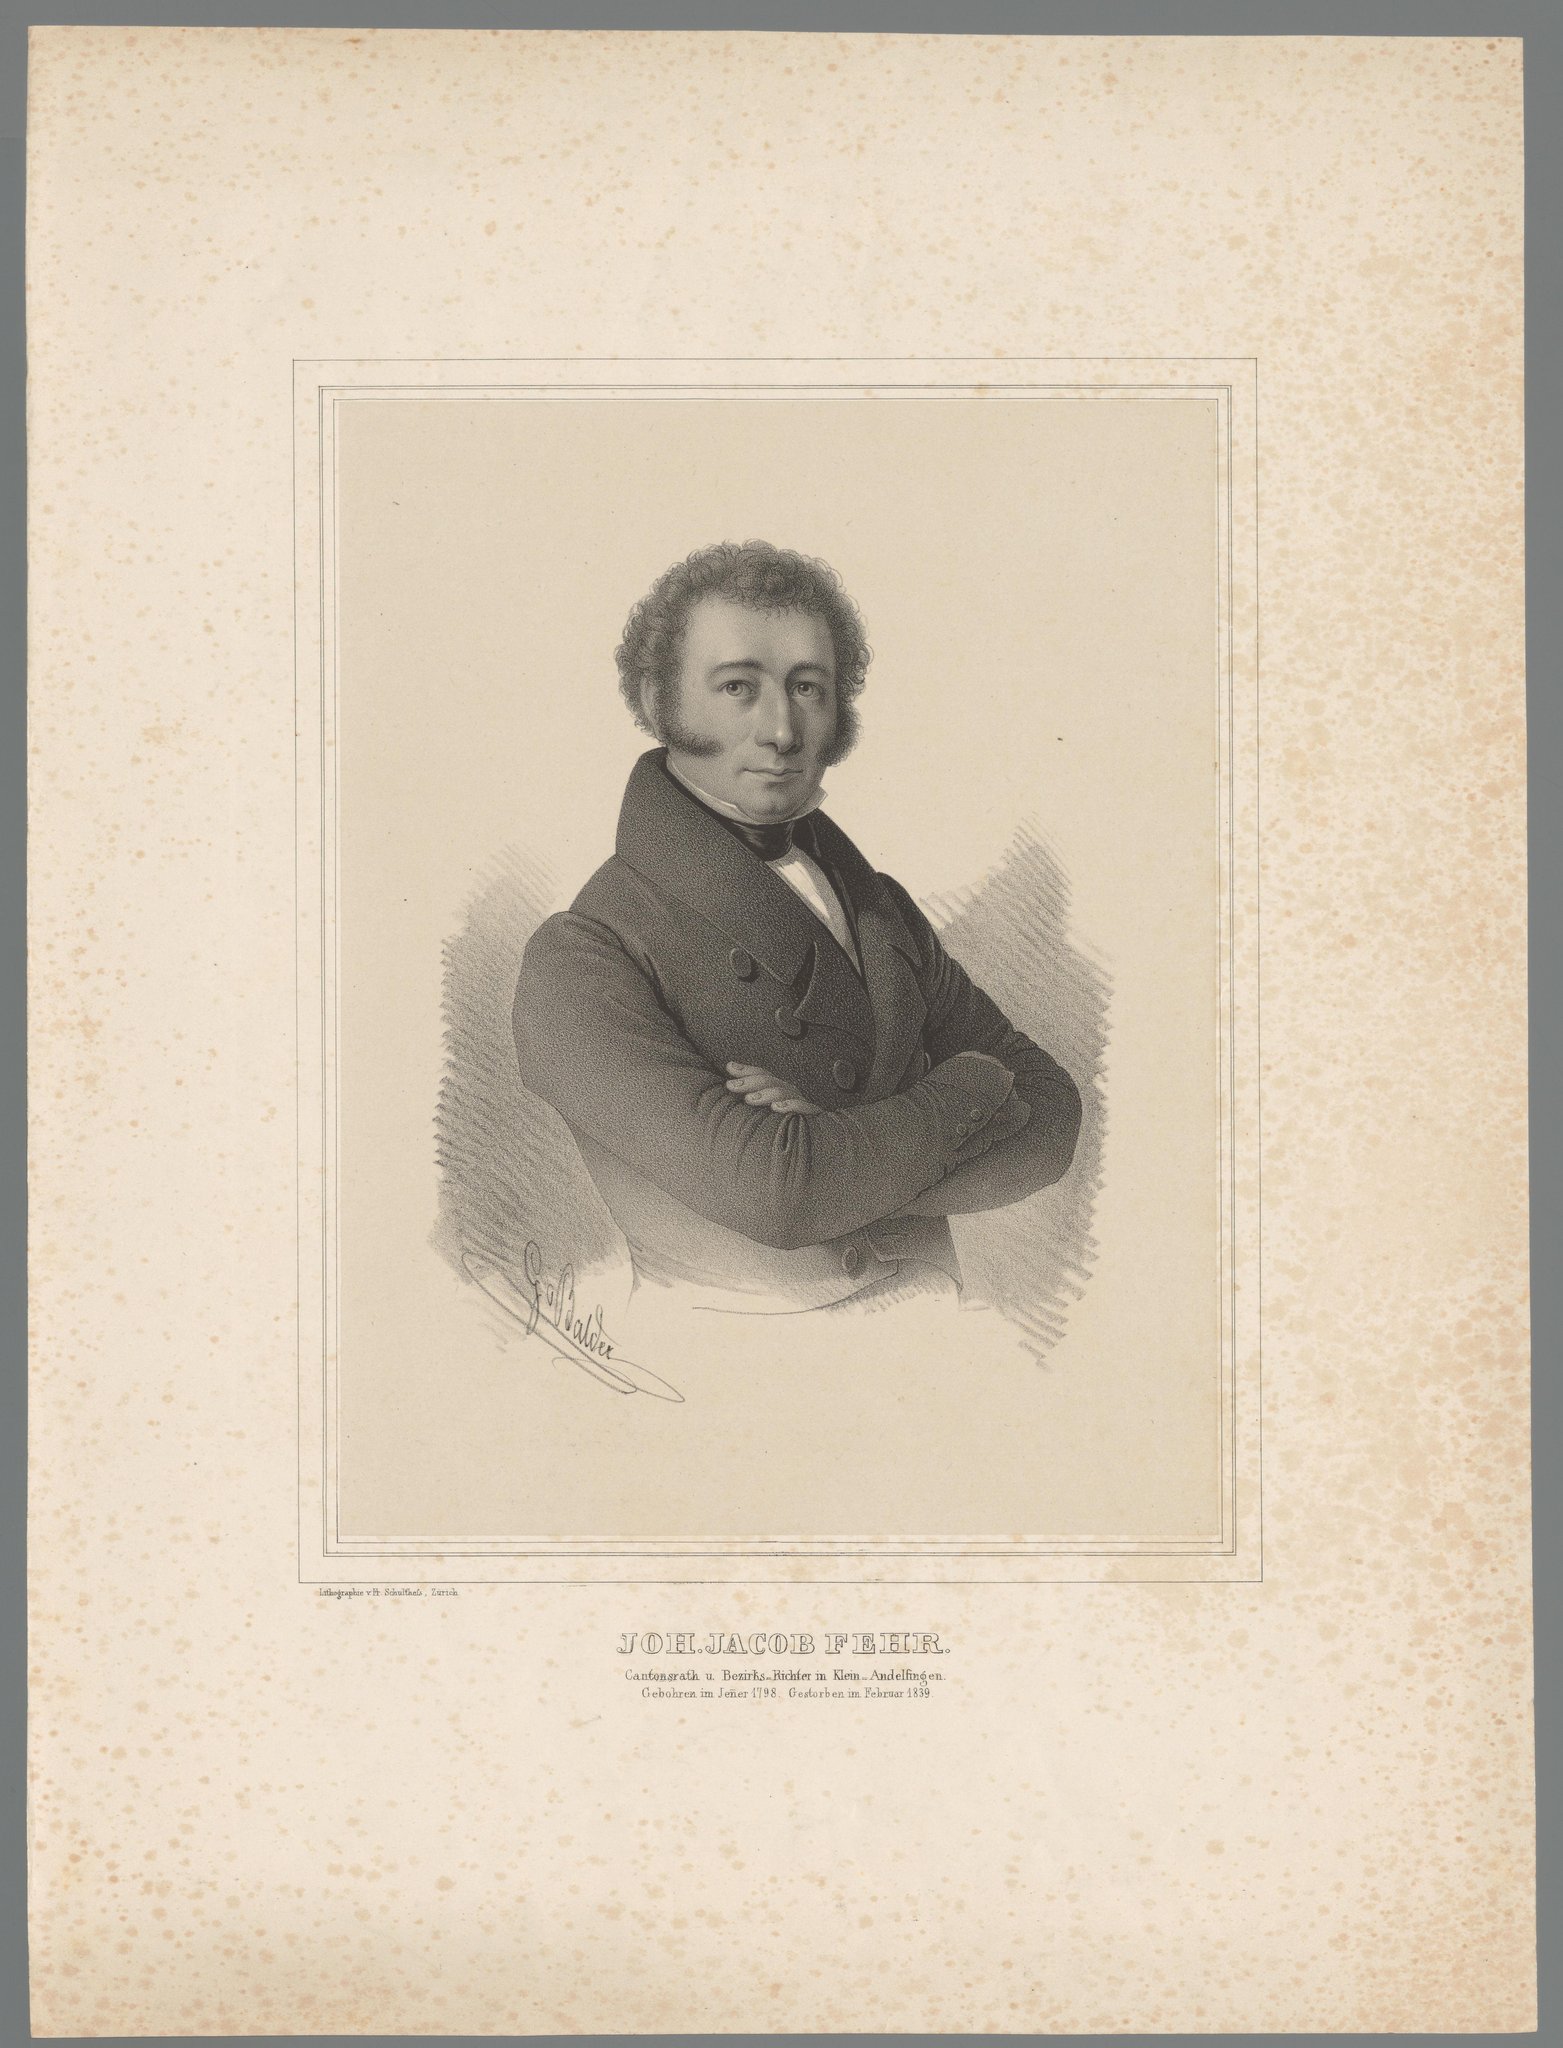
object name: print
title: Portret van Johan Jacob Fehr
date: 1820-1882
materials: paper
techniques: lithograph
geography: zurich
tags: historical persons, law and jurisprudence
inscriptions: collector's mark: Lugt 2228